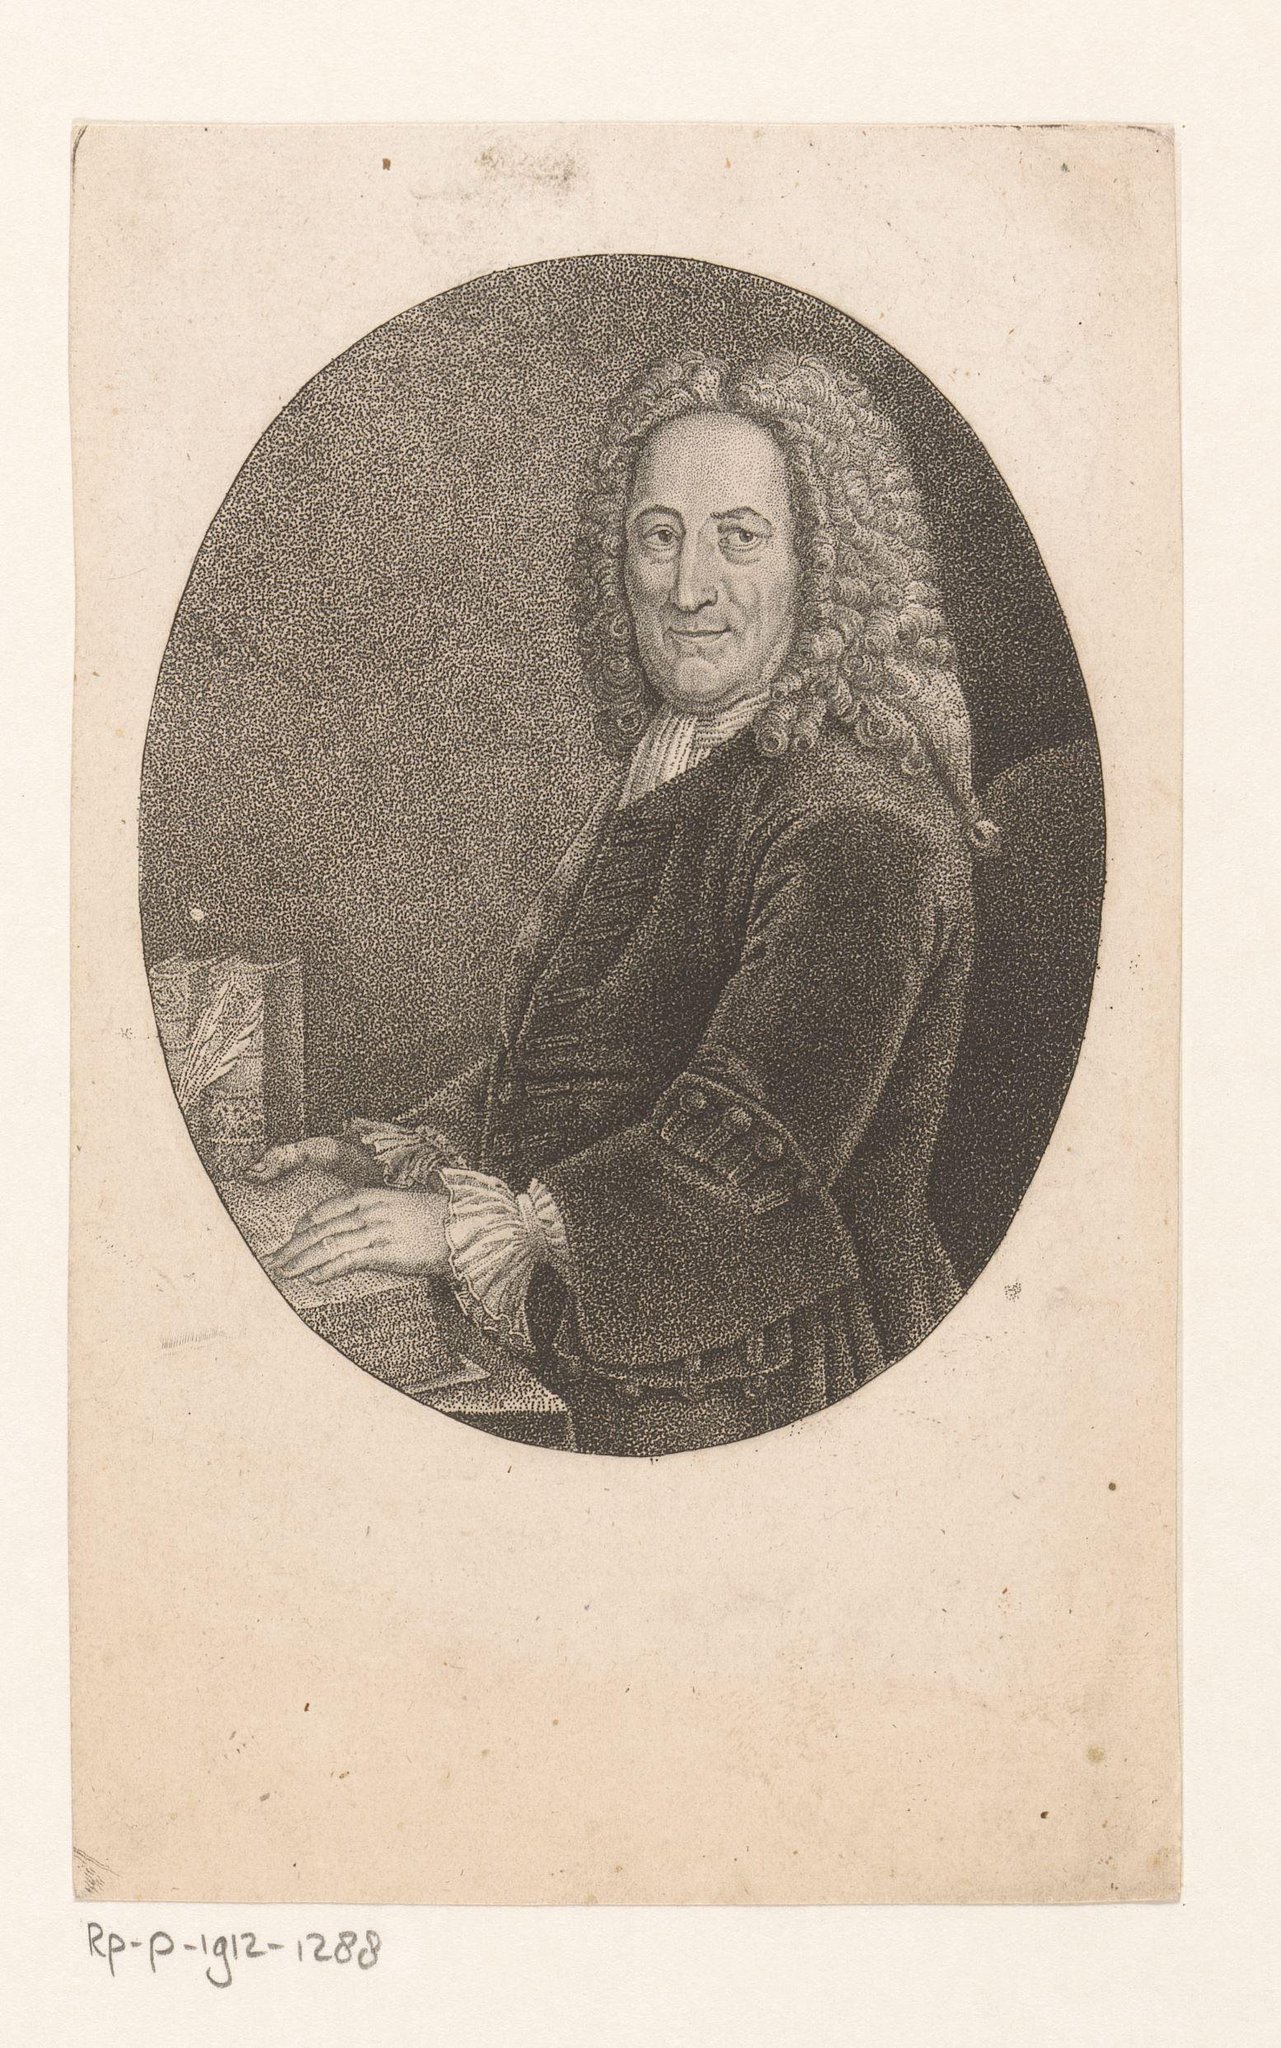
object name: print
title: Portret van Friedericus Hoffmann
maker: ambrosius gabler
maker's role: print maker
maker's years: 1762-1834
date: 1772-1834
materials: paper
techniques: engraving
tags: historical persons, book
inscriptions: collector's mark: Lugt 2228